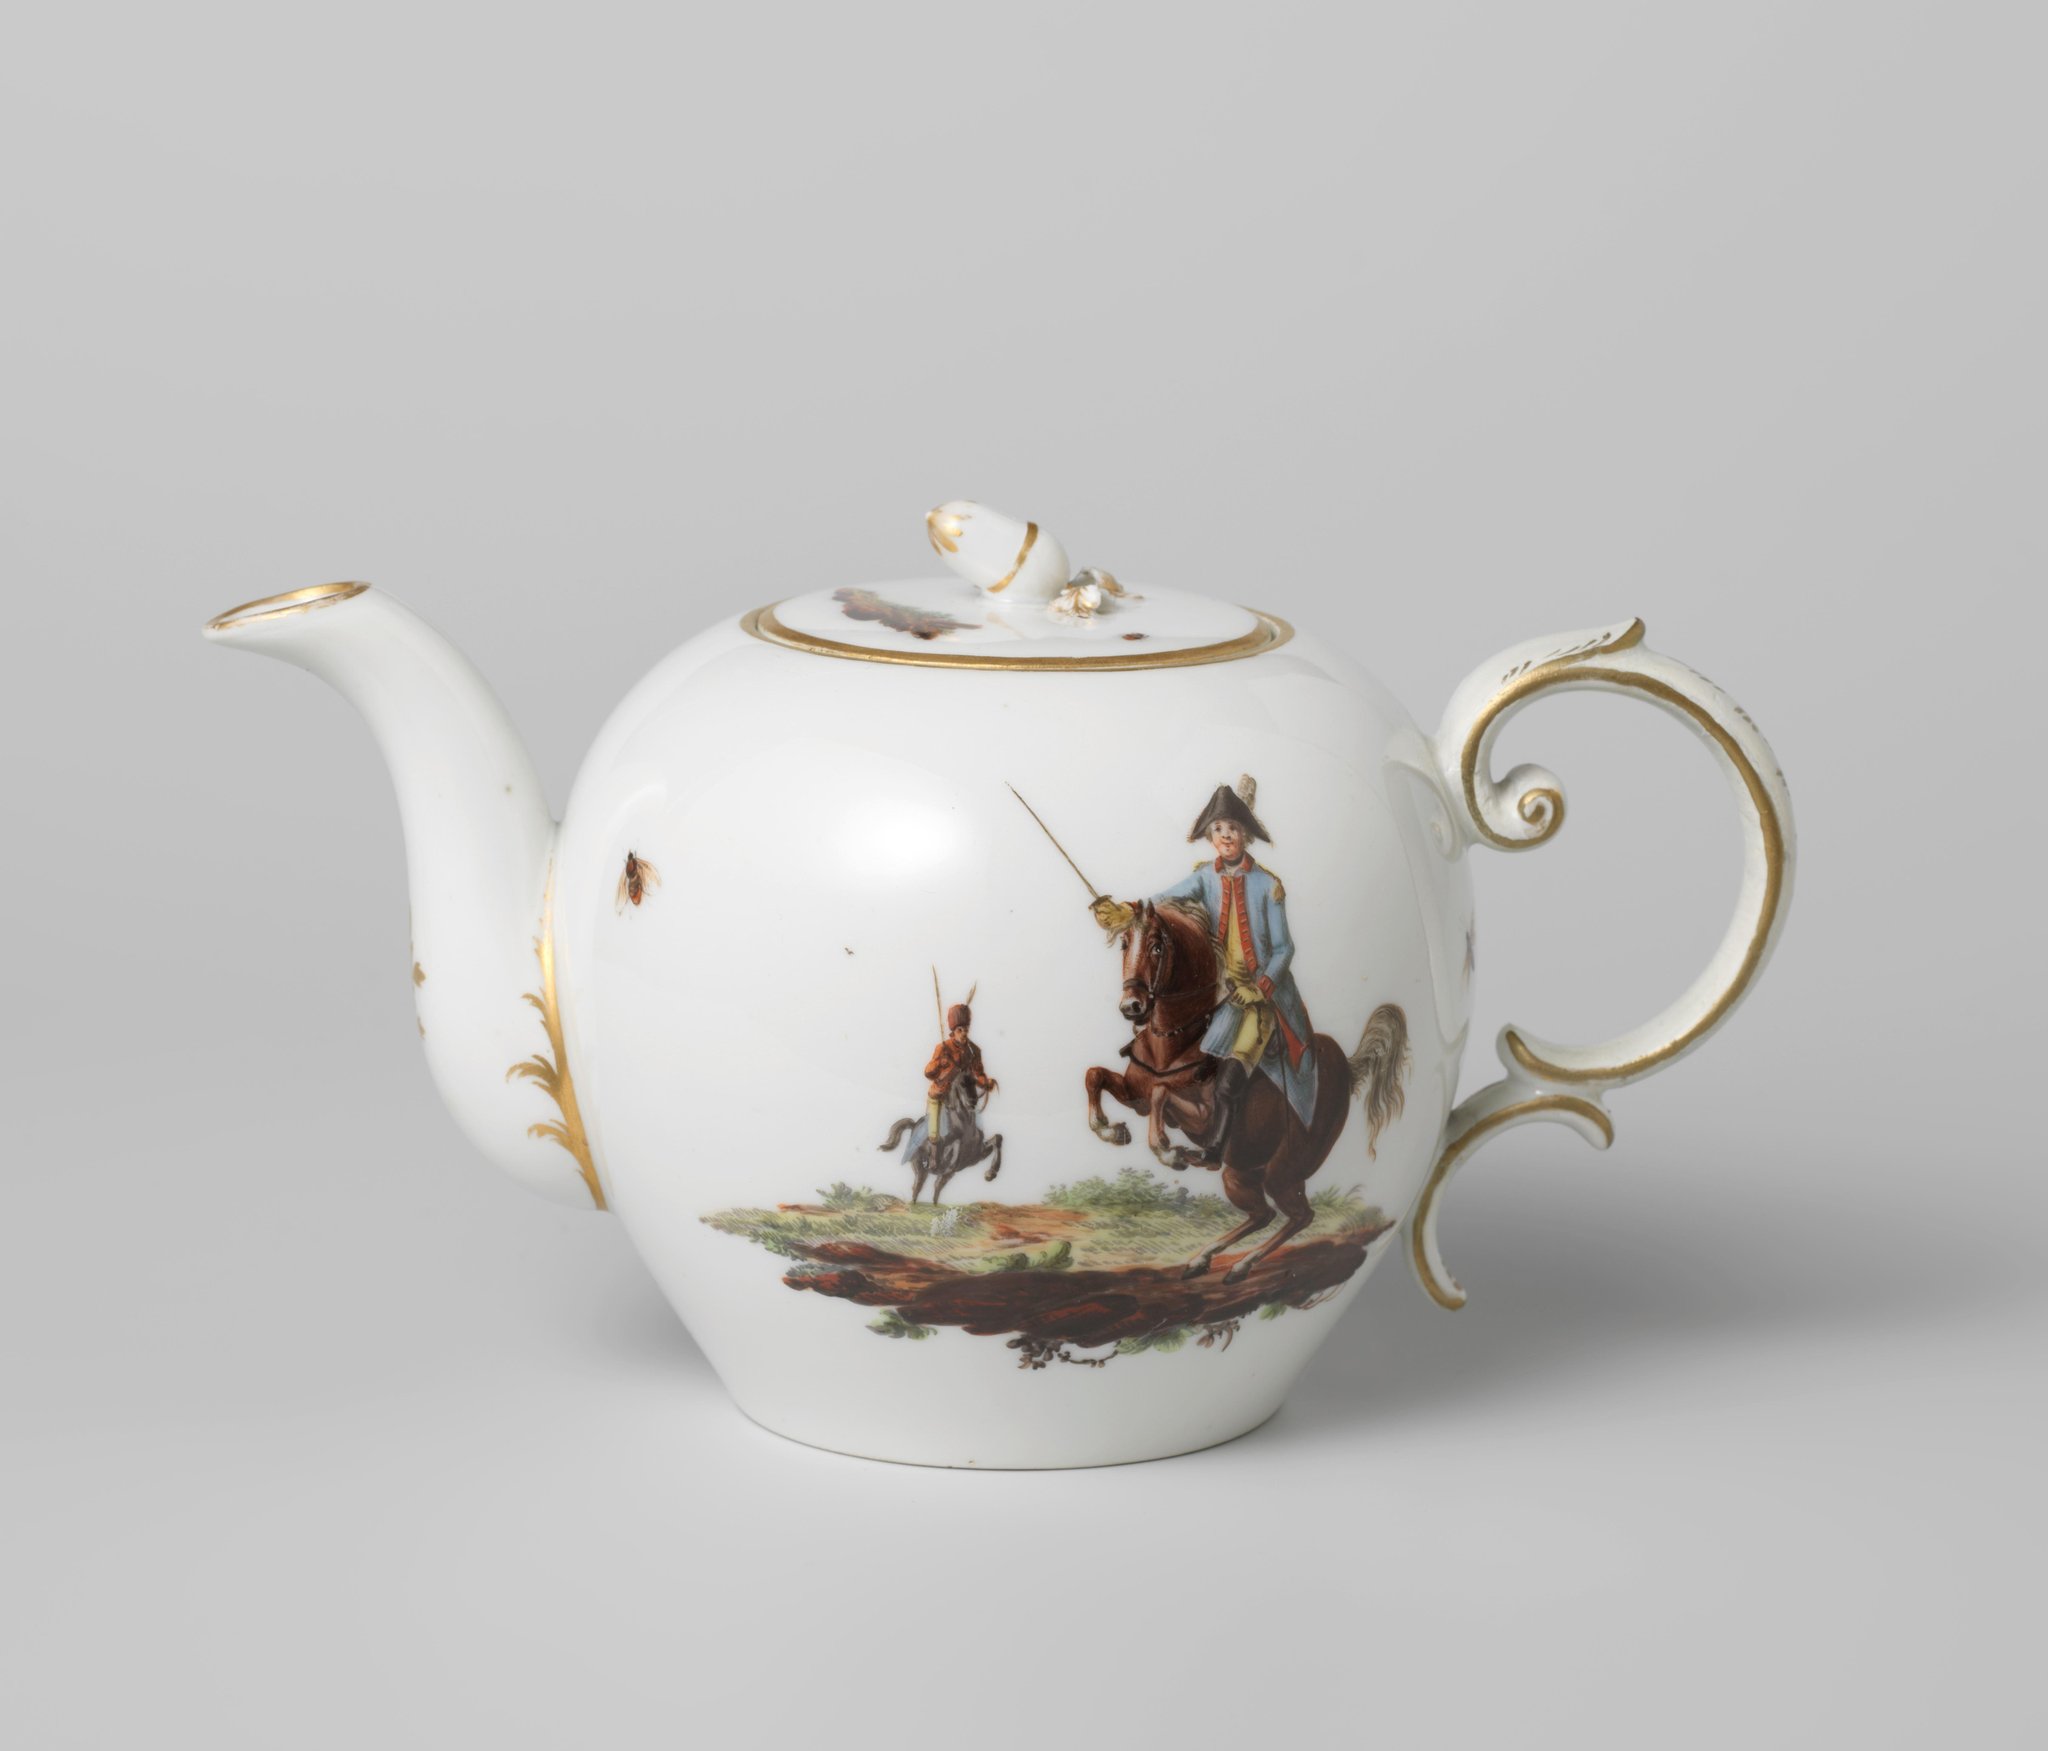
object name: teapot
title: Theepot, beschilderd met cavaleristen. Langs tuit en oor insekten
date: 1784-1809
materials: porcelain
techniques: painted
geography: ouder-amstel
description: Tea pot. Porcelain. Ouder-Amstel, c. 1785 - 1800. Factory under the direction of Friedrich Daeuber. J.G.A.N. de Vries bequest, 1925.